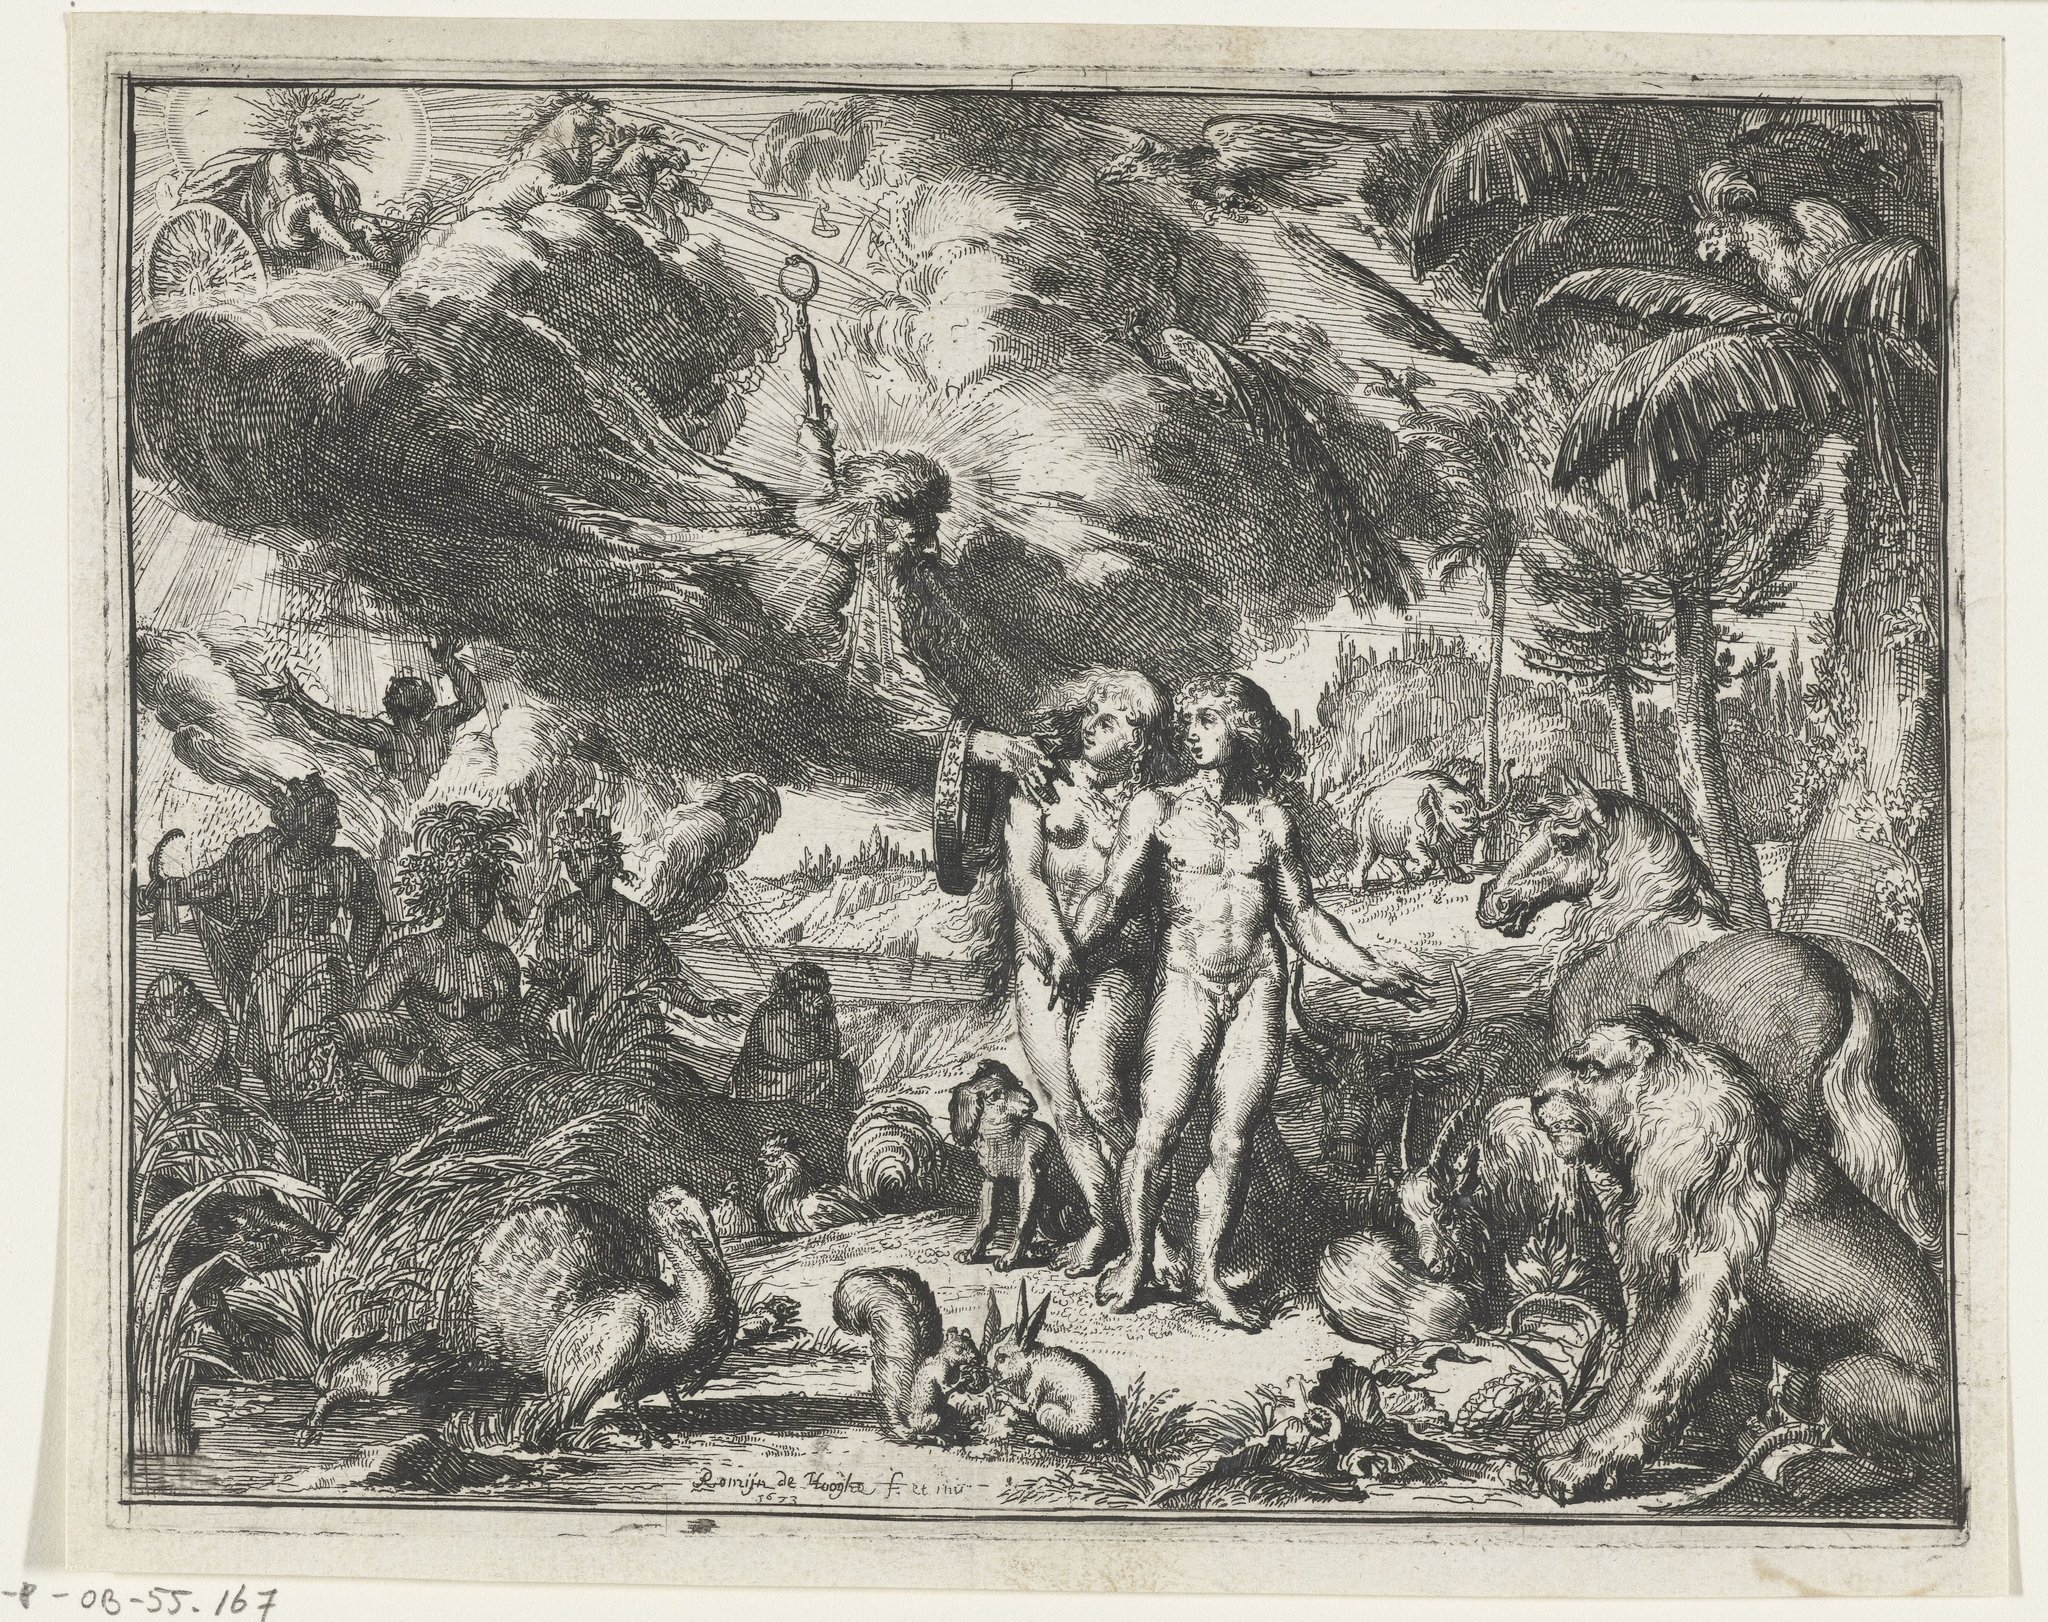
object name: print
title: Adam en Eva in het paradijs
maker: romeyn de hooghe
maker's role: draughtsman, goldsmith, painter, print maker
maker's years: 1645-1708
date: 1673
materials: paper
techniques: engraving, etching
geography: netherlands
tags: adam and eve in paradise (before the fall)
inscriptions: date